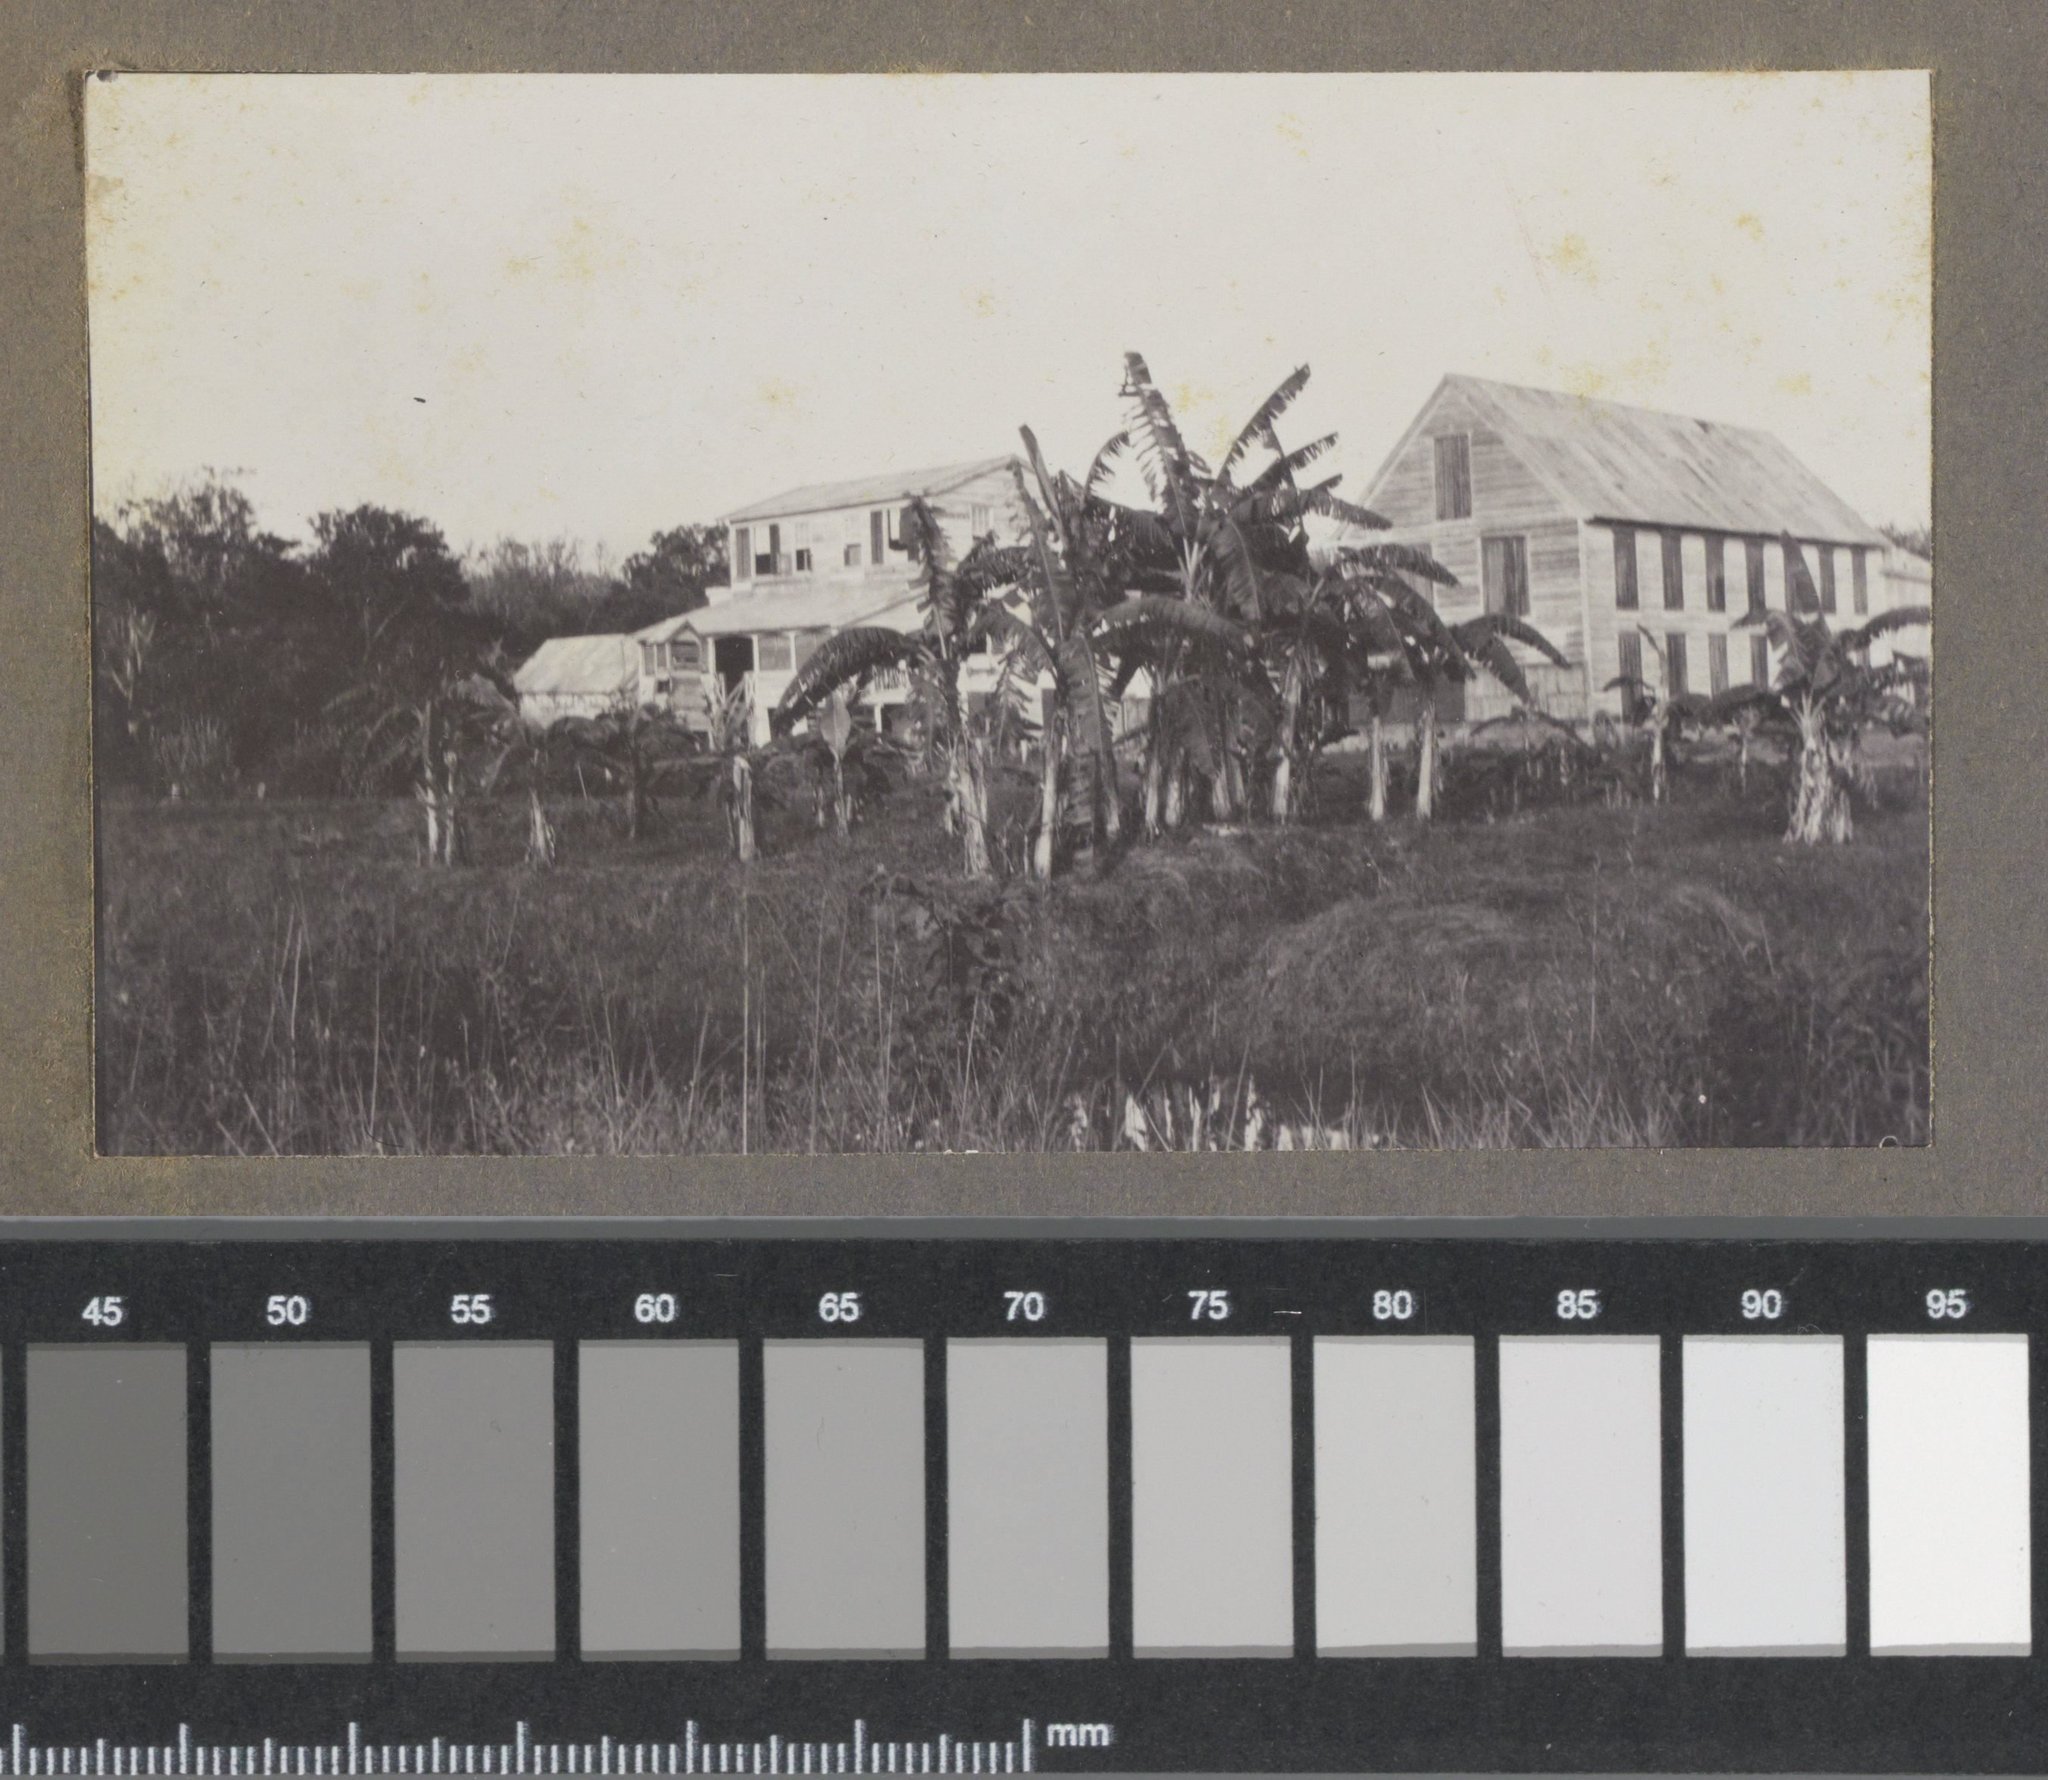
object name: photograph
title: Huis op Plantage Clevia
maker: Anonymous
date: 1912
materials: photographic support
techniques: photography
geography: suriname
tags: plantation, suriname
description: Gezicht op het huis en een grote schuur op Plantage Clevia, voor het huis enkele bananenbomen. Onderdeel van het fotoalbum over het leven van de familie Gonggrijp in Suriname rond 1912.